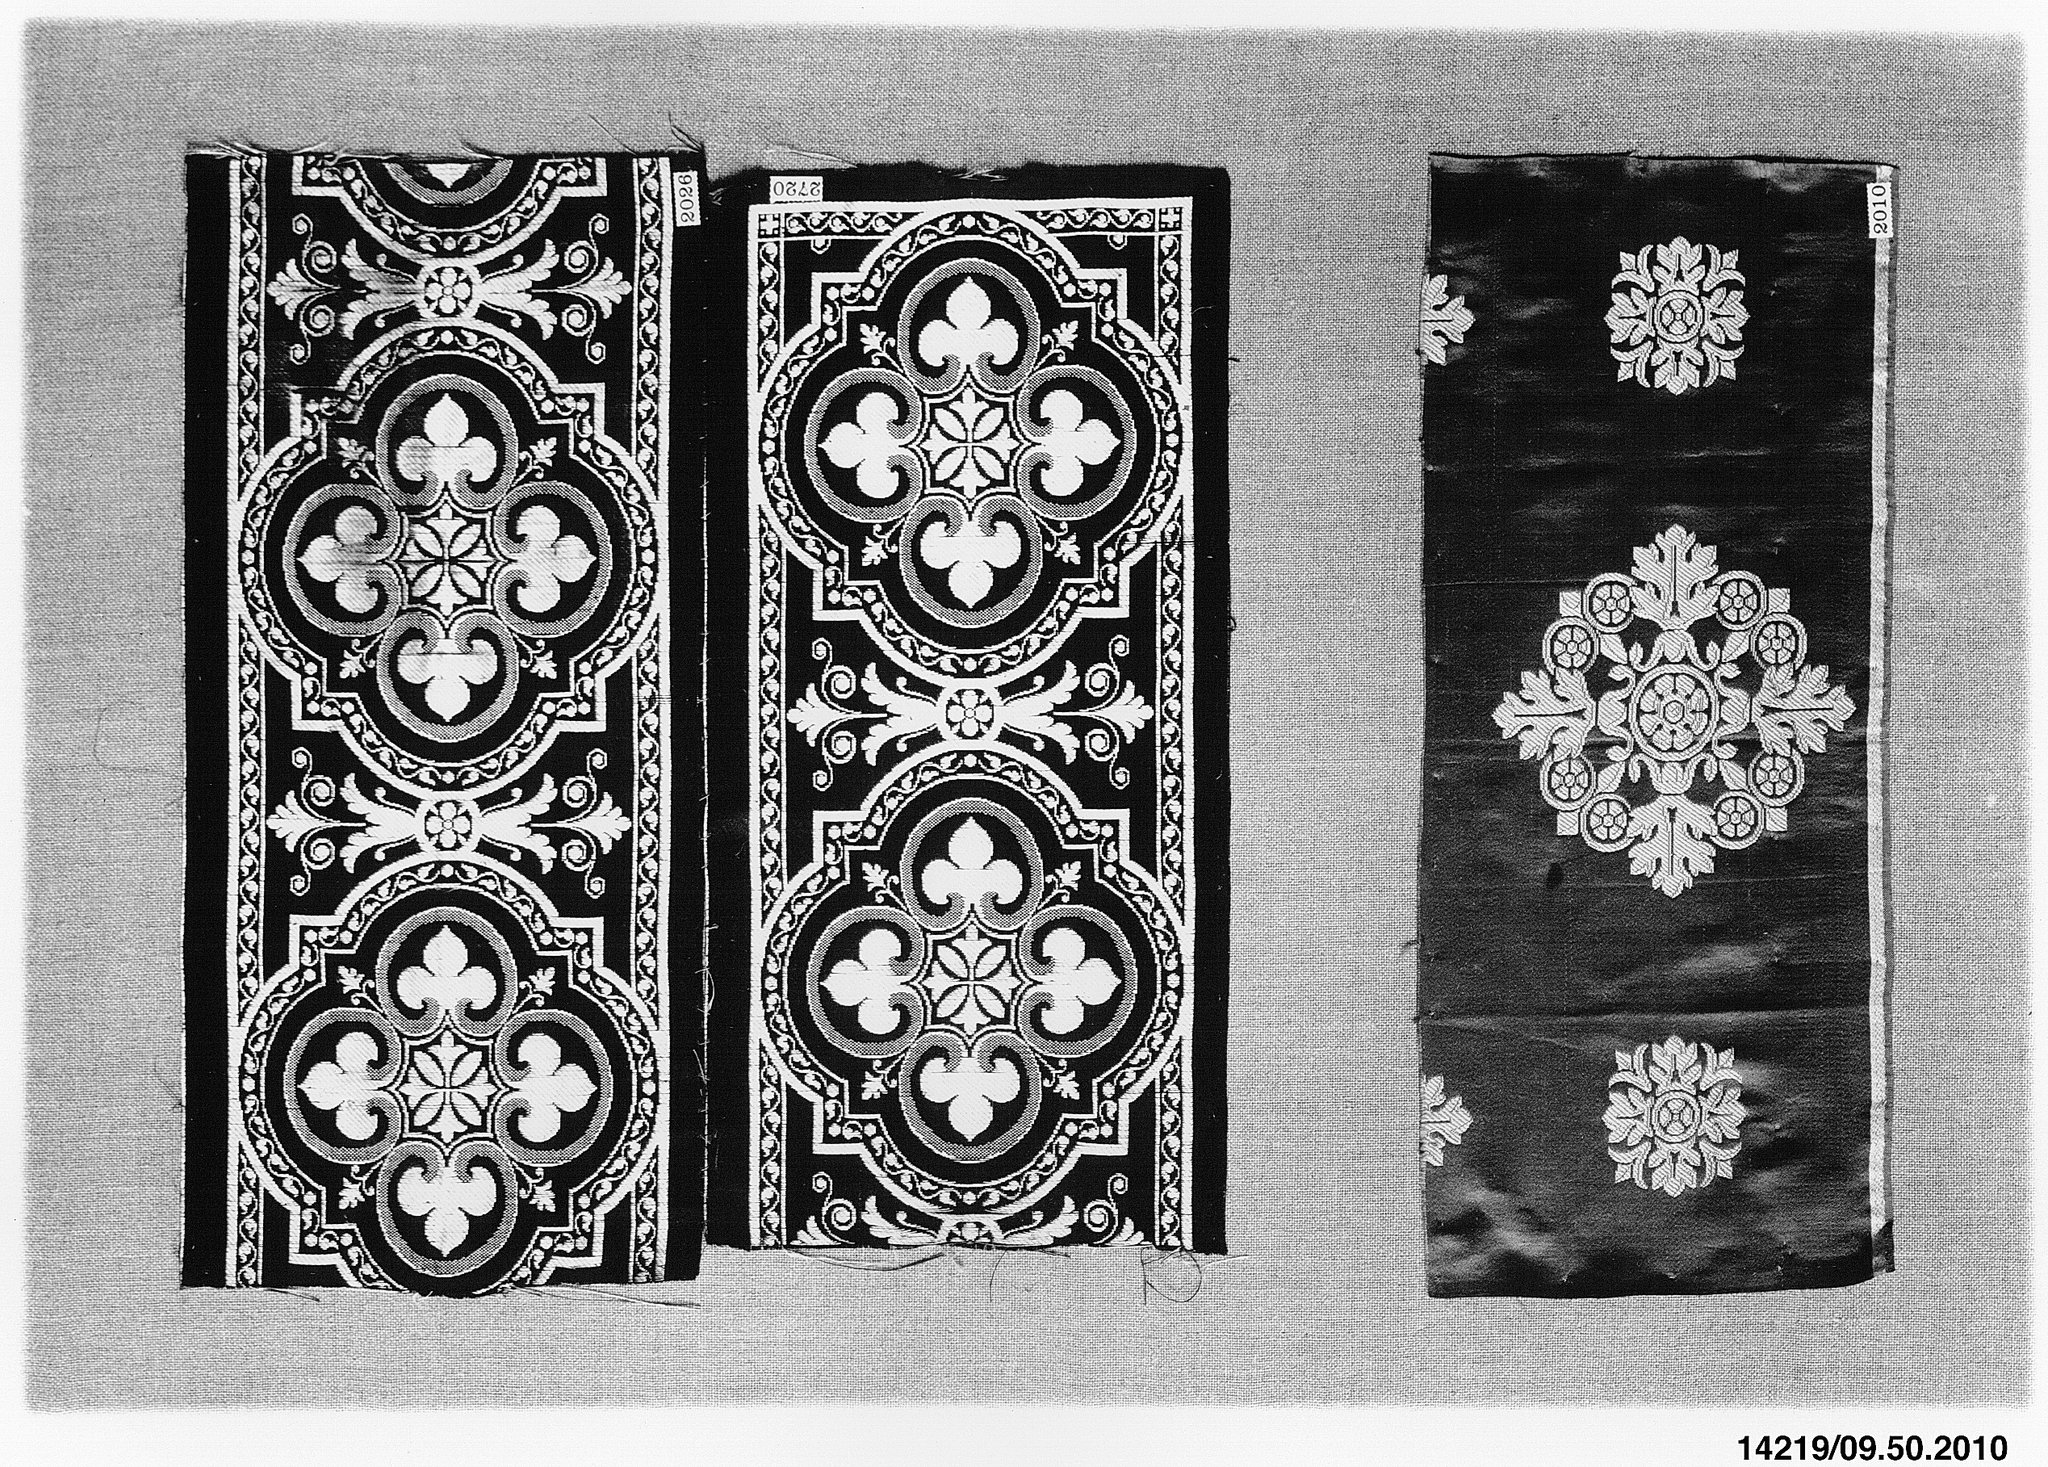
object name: piece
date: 1701-1733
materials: silk